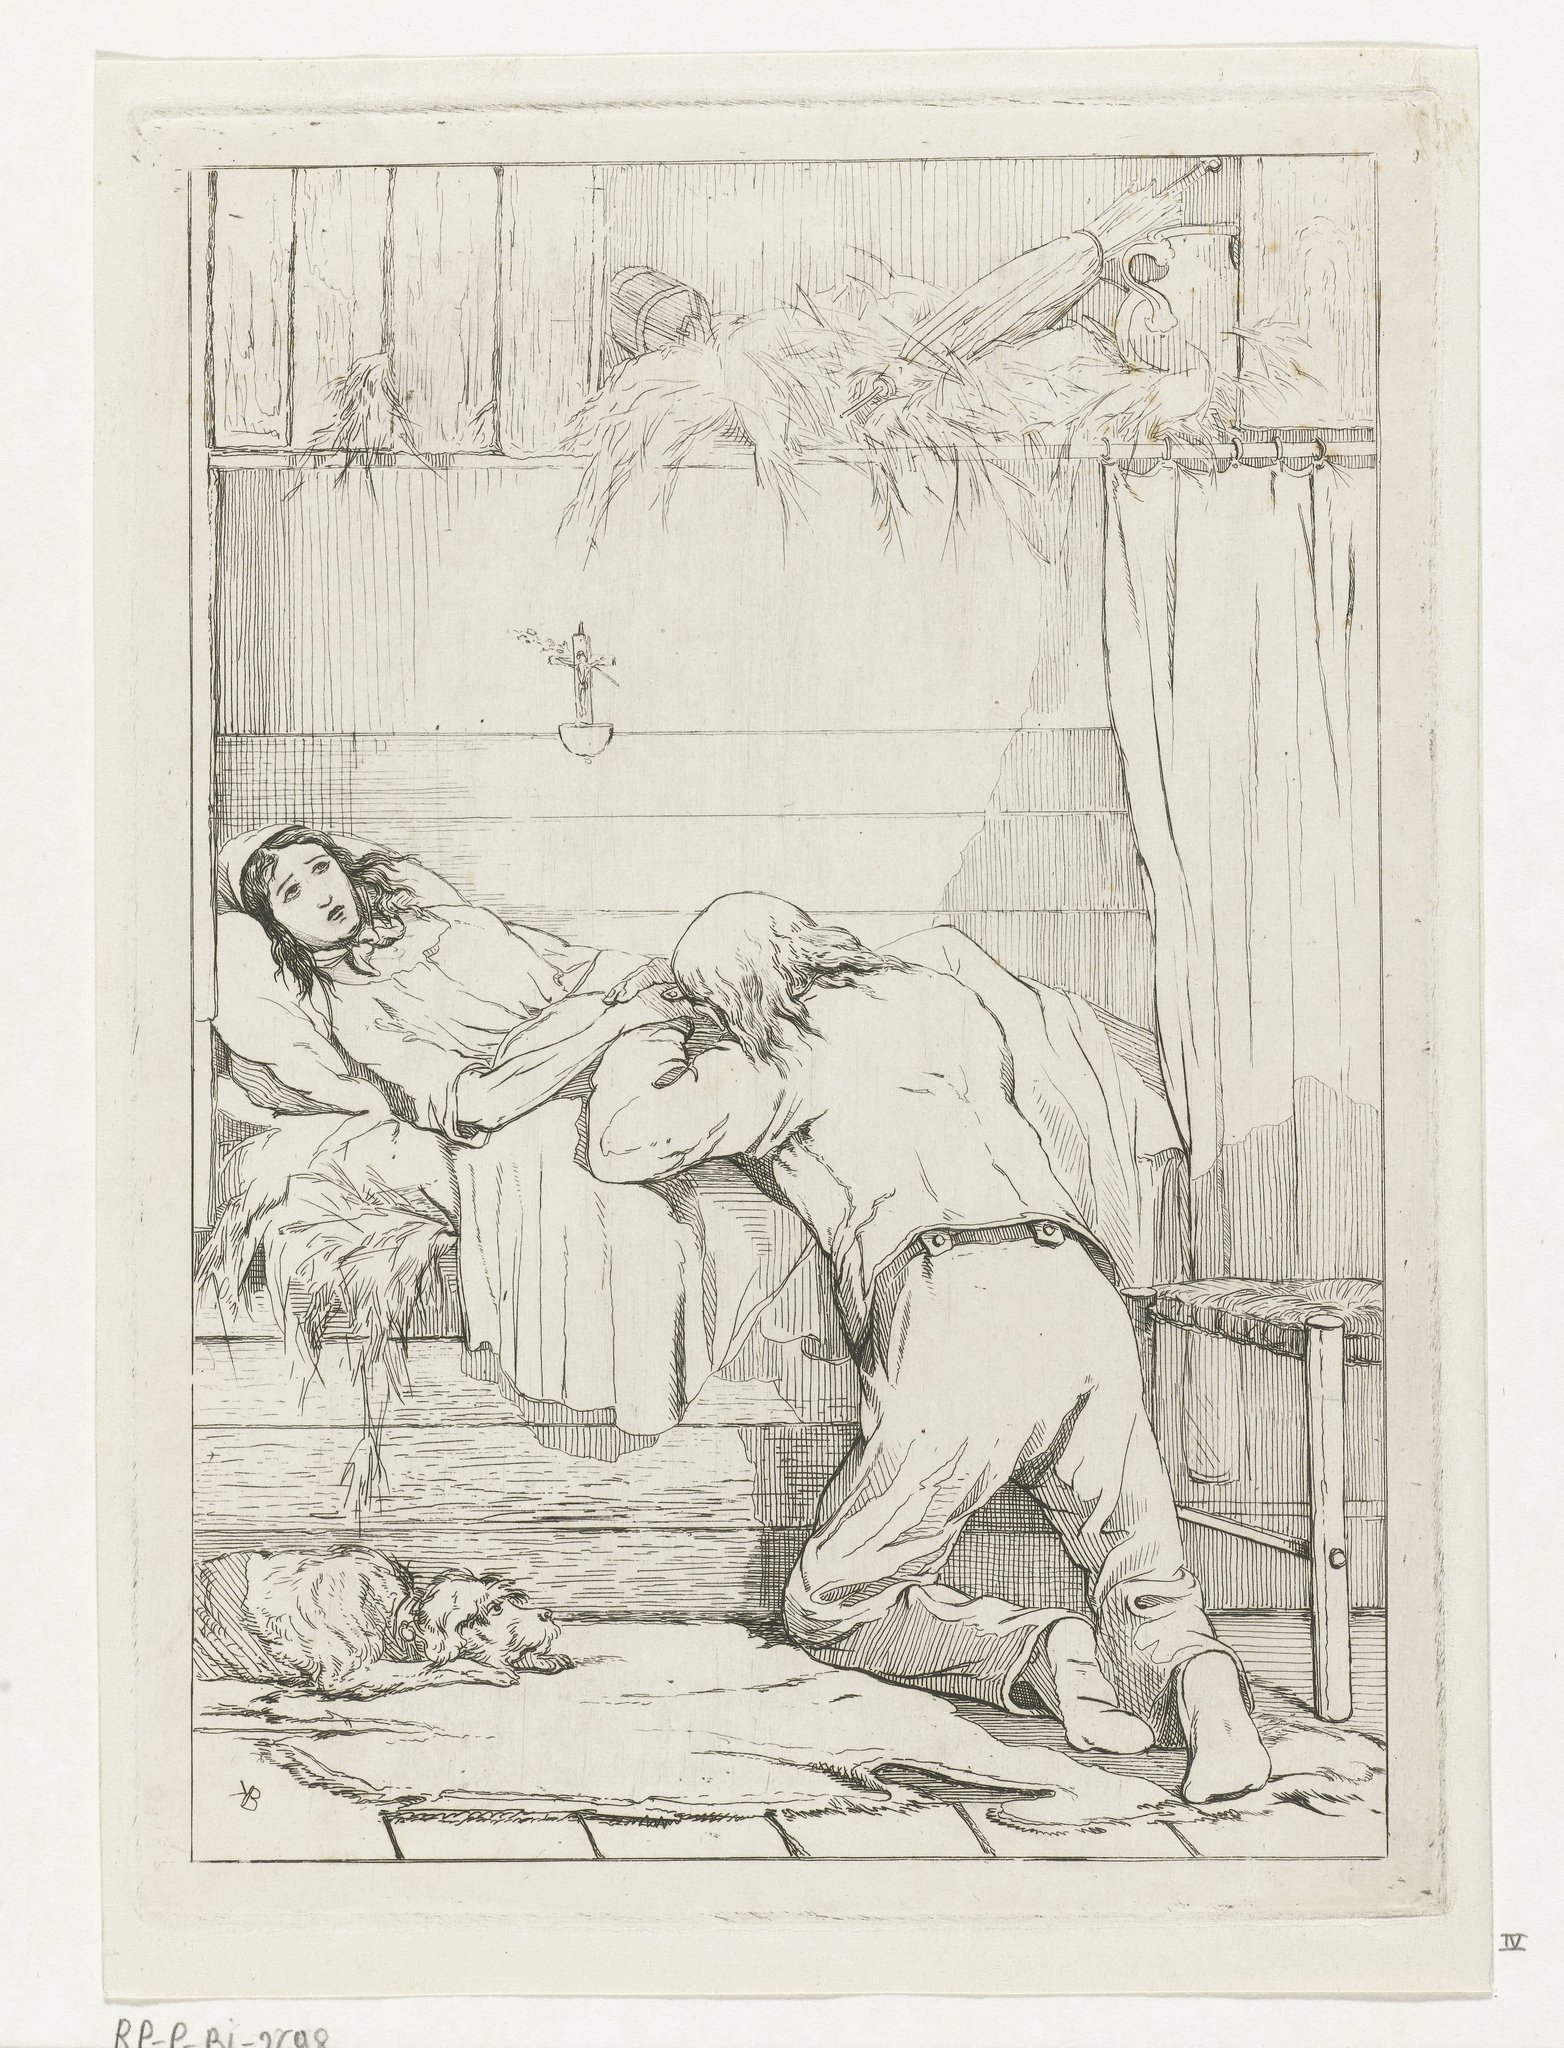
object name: print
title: Sterfbed van een geliefde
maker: karel frederik bombled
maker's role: draughtsman, print maker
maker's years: 1822-1902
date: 1832-1902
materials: paper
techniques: etching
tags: deathbed, crucifix ~ personal devotion, couple of lovers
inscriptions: collector's mark: Lugt 2228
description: Een jonge vrouw ligt ziek en stervend in een bedstee. Haar man houdt haar hand vast en begraaft zijn hoofd in de dekens. Een hond ligt stil naast het bed. Aan de wand van het bed hangt een kruisbeeldje.